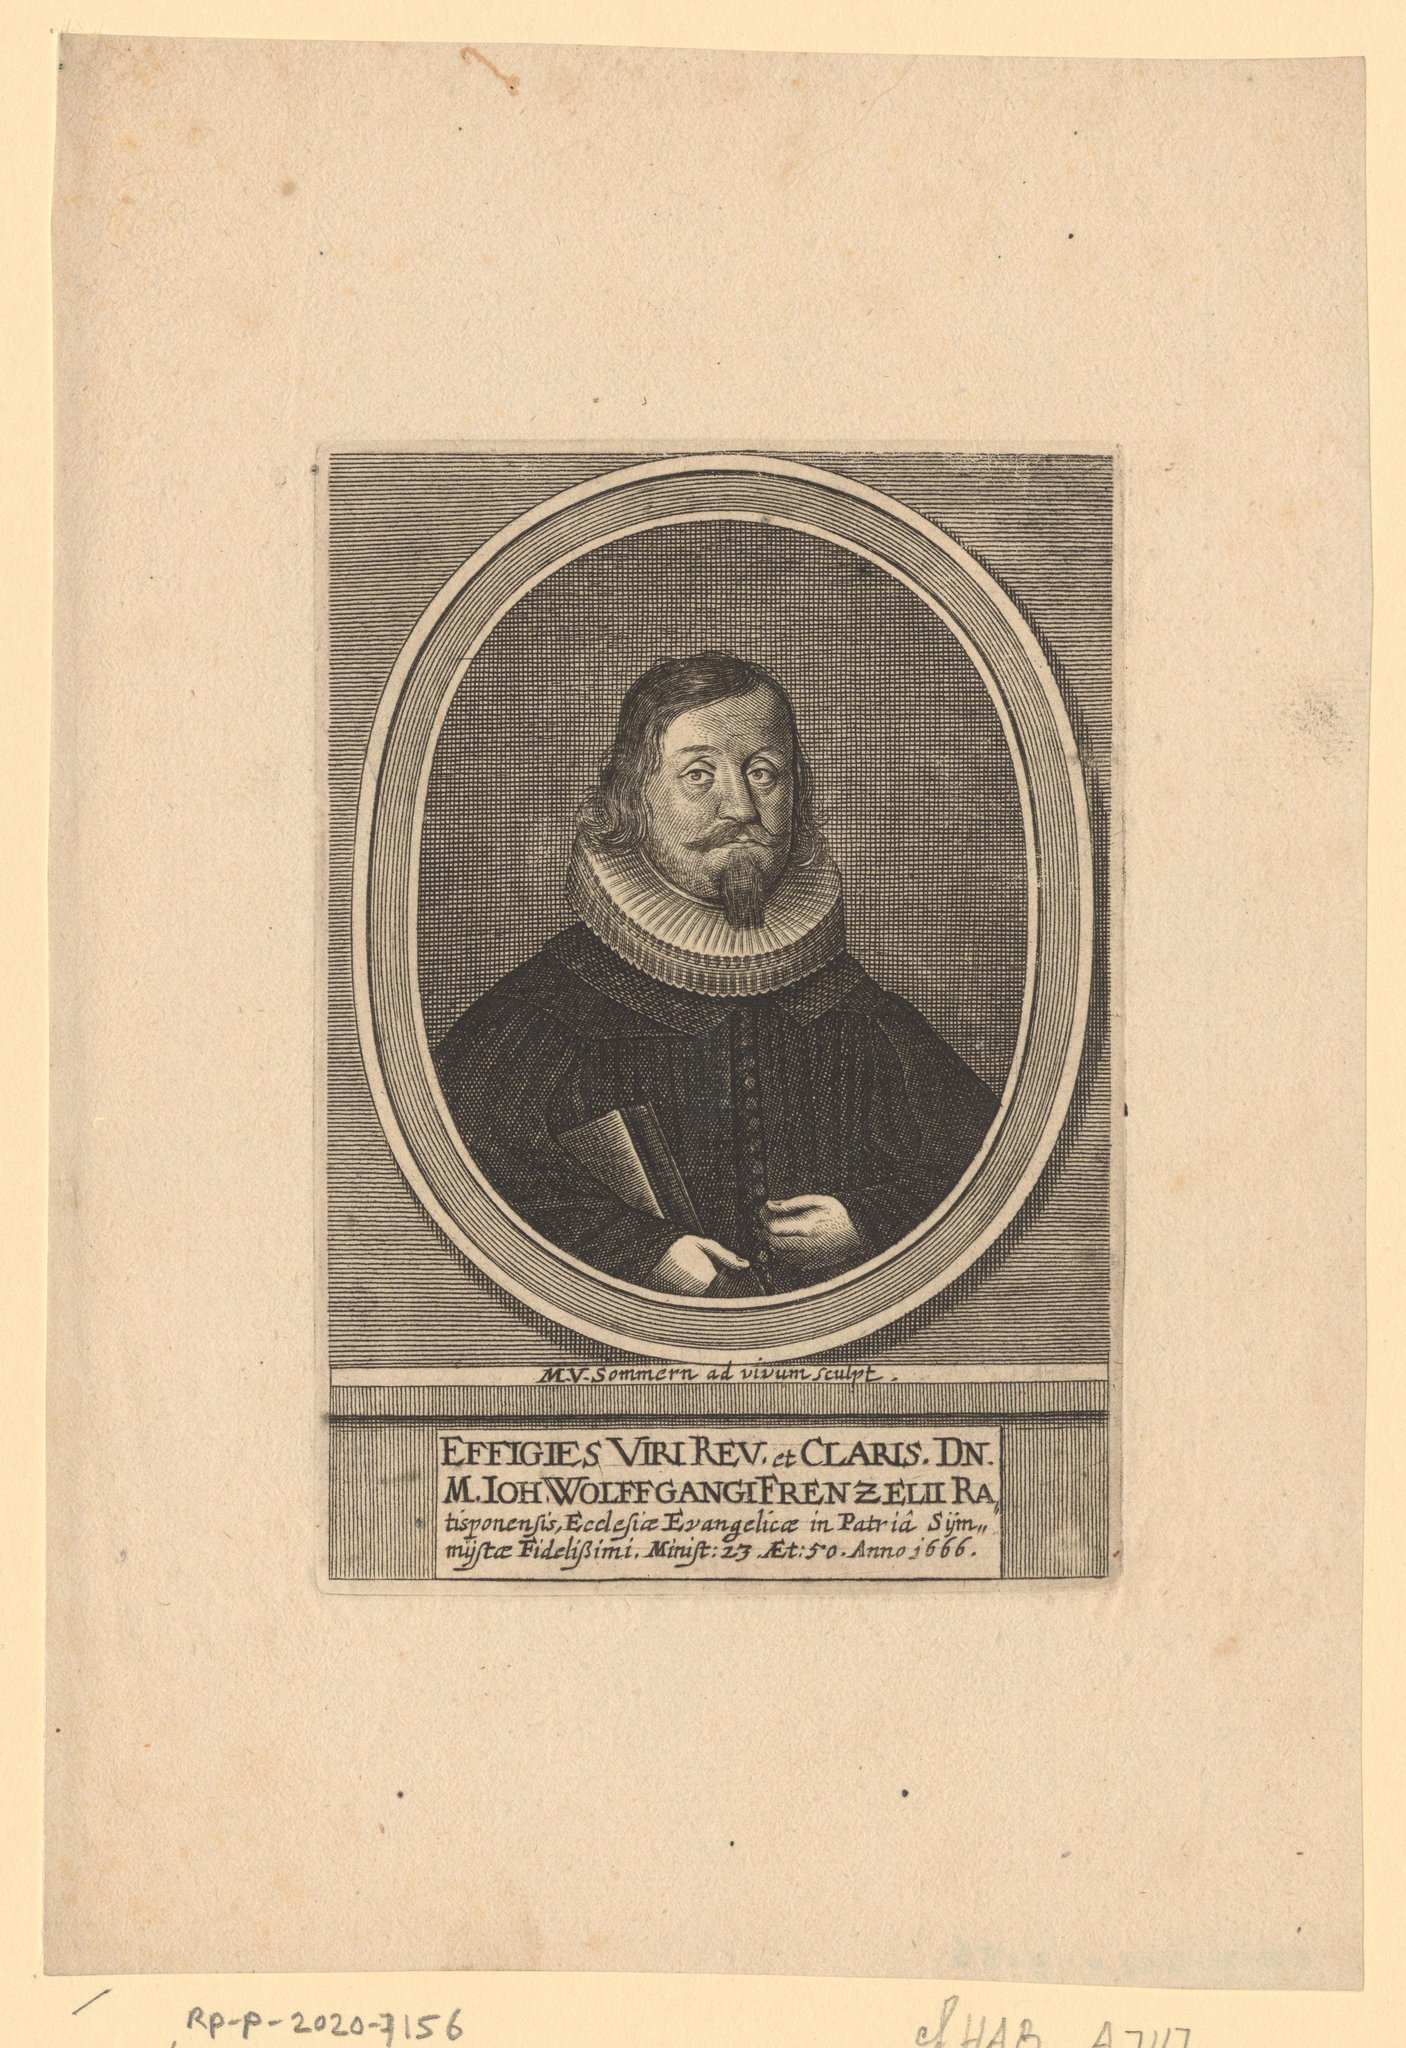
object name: print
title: Portret van Johann Wolfgang Frenzel op 50-jarige leeftijd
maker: matthias van sommer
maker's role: draughtsman, print maker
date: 1666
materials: paper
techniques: engraving, etching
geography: germany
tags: historical persons, book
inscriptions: date